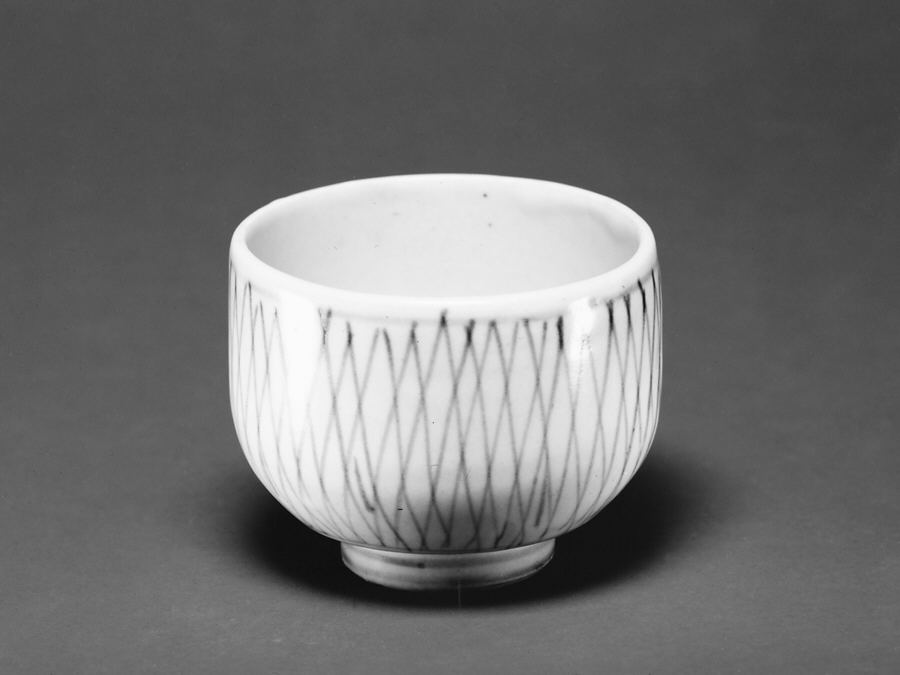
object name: soba cup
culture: japanese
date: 1615-1868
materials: porcelain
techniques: underglaze